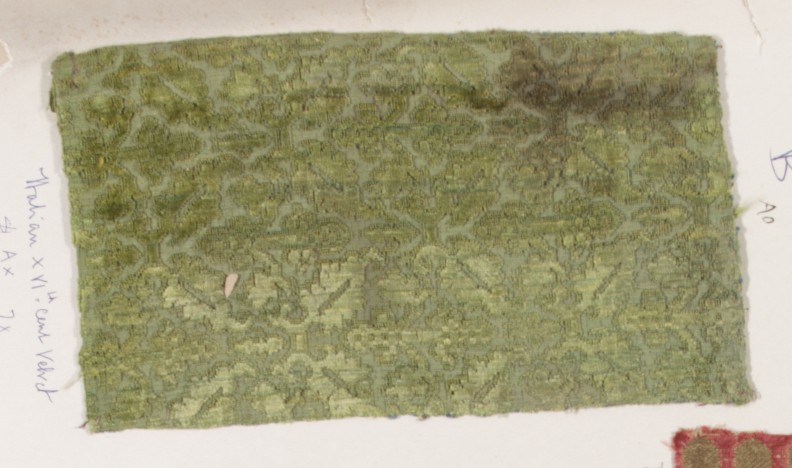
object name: fragment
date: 1501-1700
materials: silk